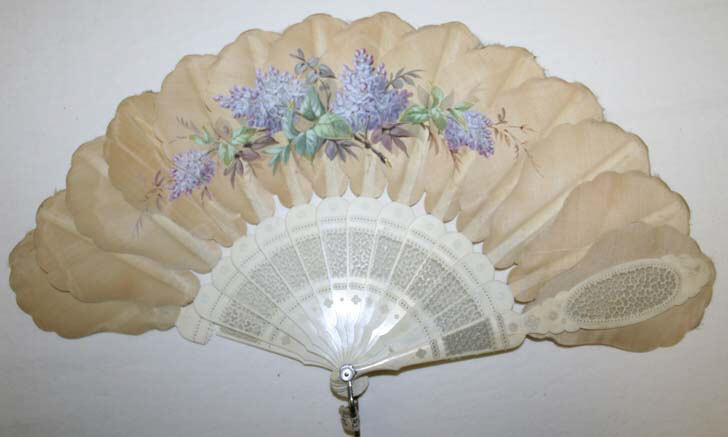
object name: fan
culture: french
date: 1867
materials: silk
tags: flowers